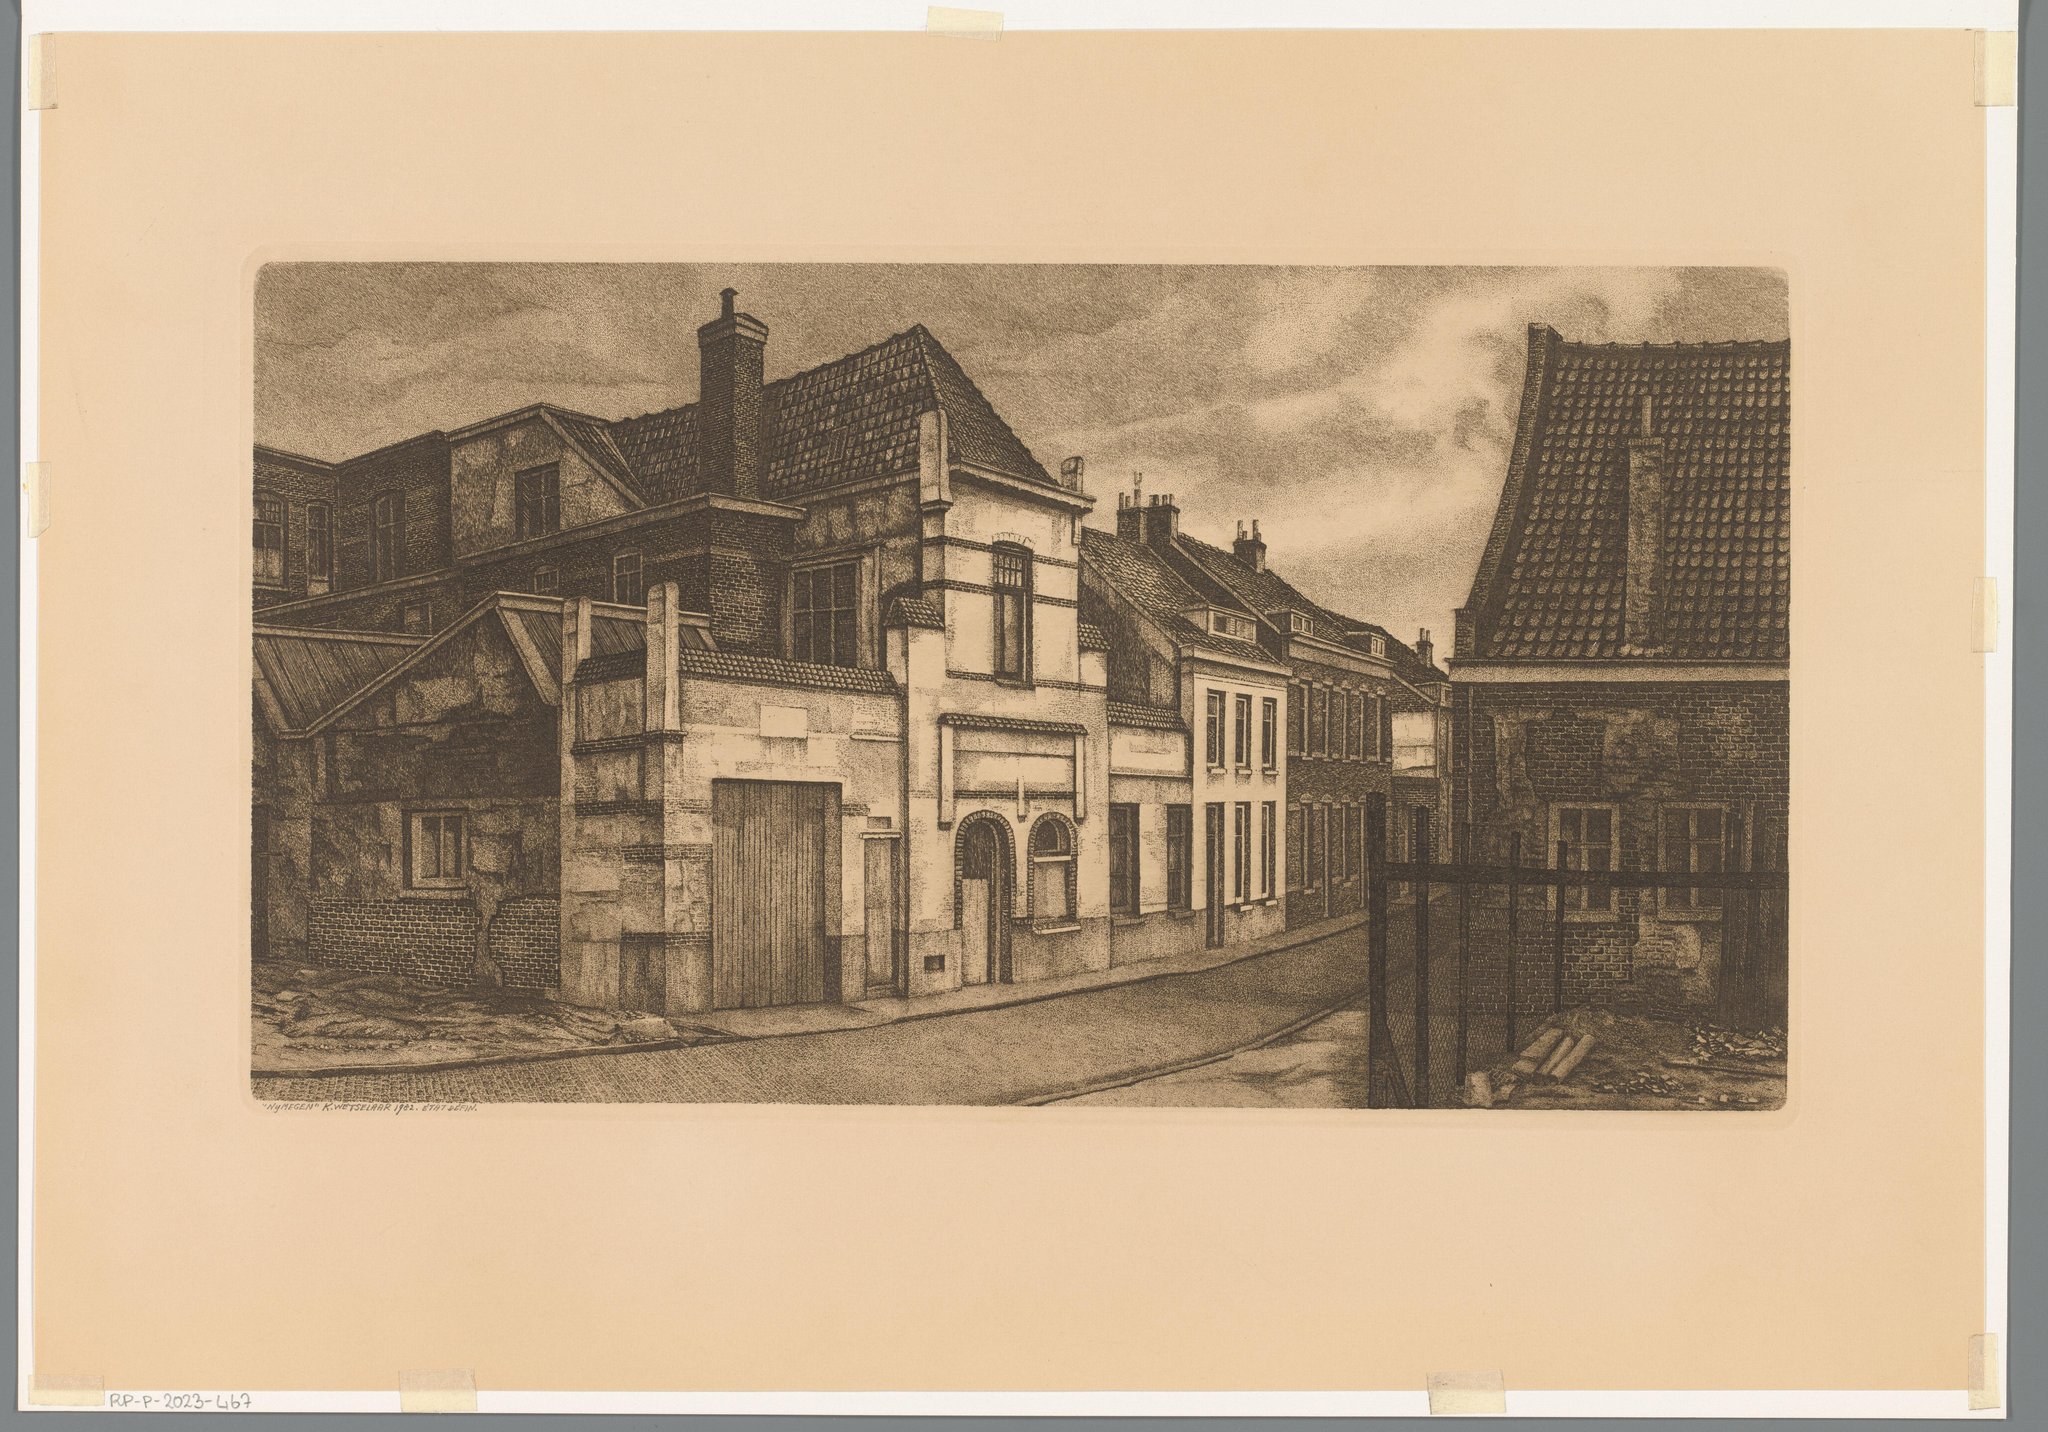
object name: print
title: Nijmegen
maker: karel wetselaar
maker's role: print maker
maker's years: 1935-2017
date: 1982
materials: paper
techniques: etching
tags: city-view in general; 'veduta', street, nijmegen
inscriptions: signature and date: ‘K. Wetselaar 1982’, inscription: ‘état défin’